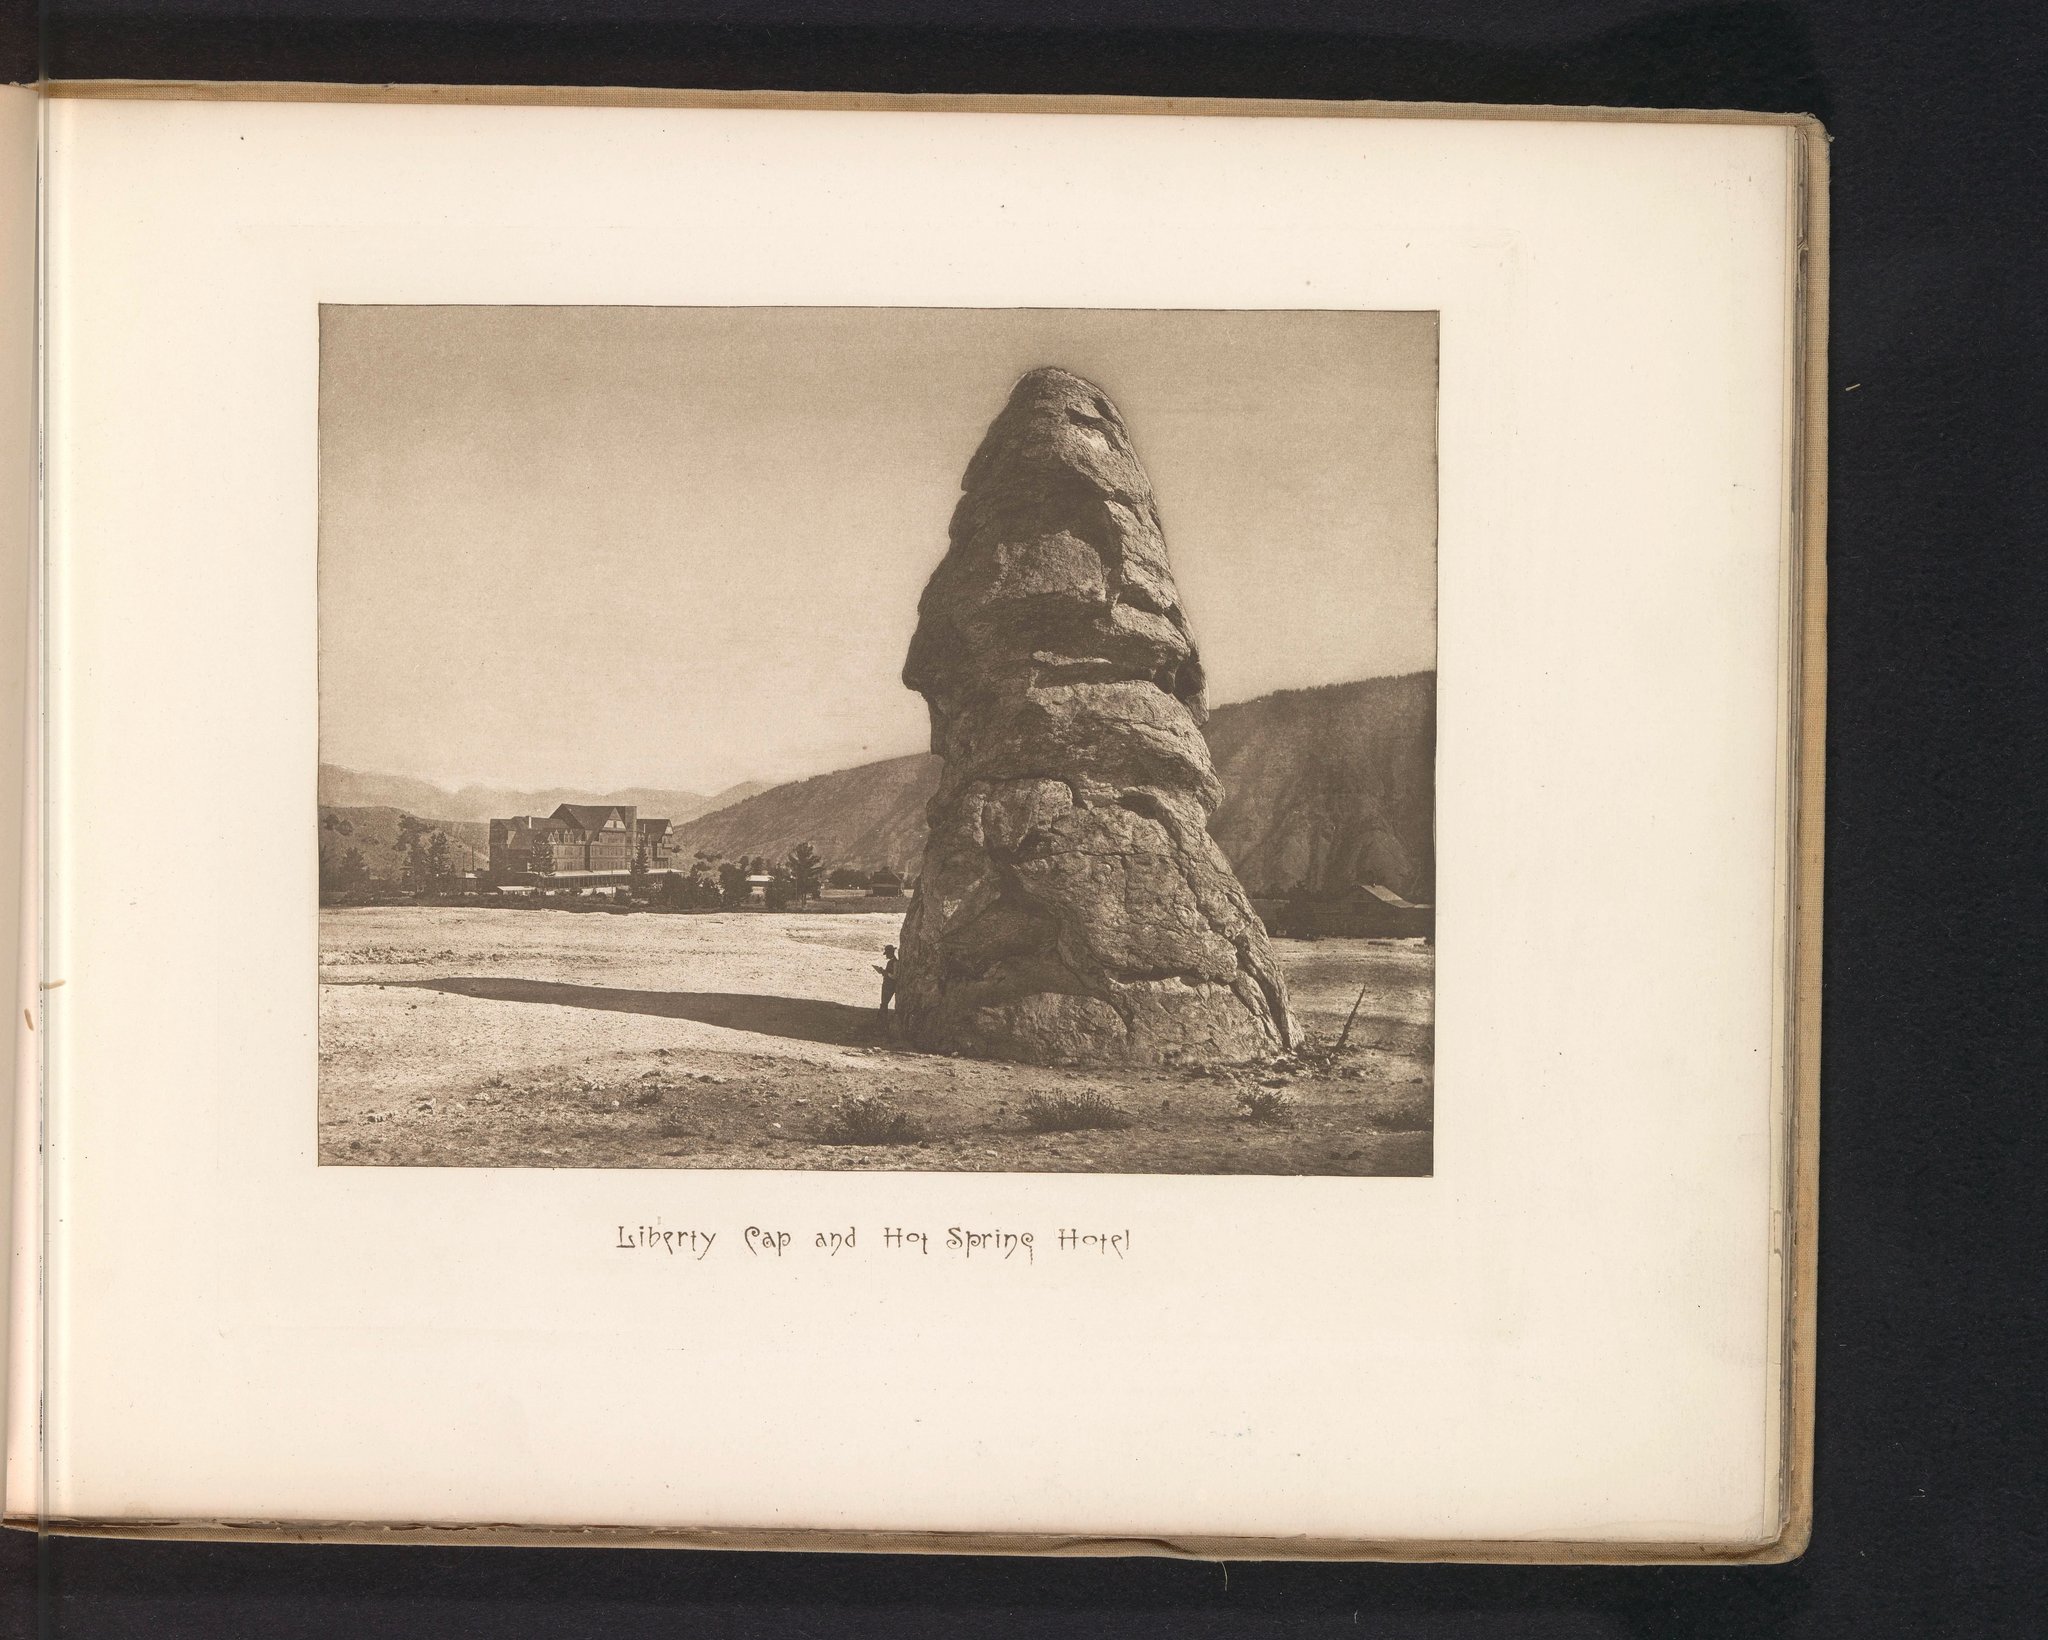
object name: page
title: Liberty Cap and hot spring hotel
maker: frank jay haynes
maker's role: fotograaf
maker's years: 1853-1921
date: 1882-1887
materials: paper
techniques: photoaquatint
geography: yellowstone national park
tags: rock-formations, hotel, hostelry, inn